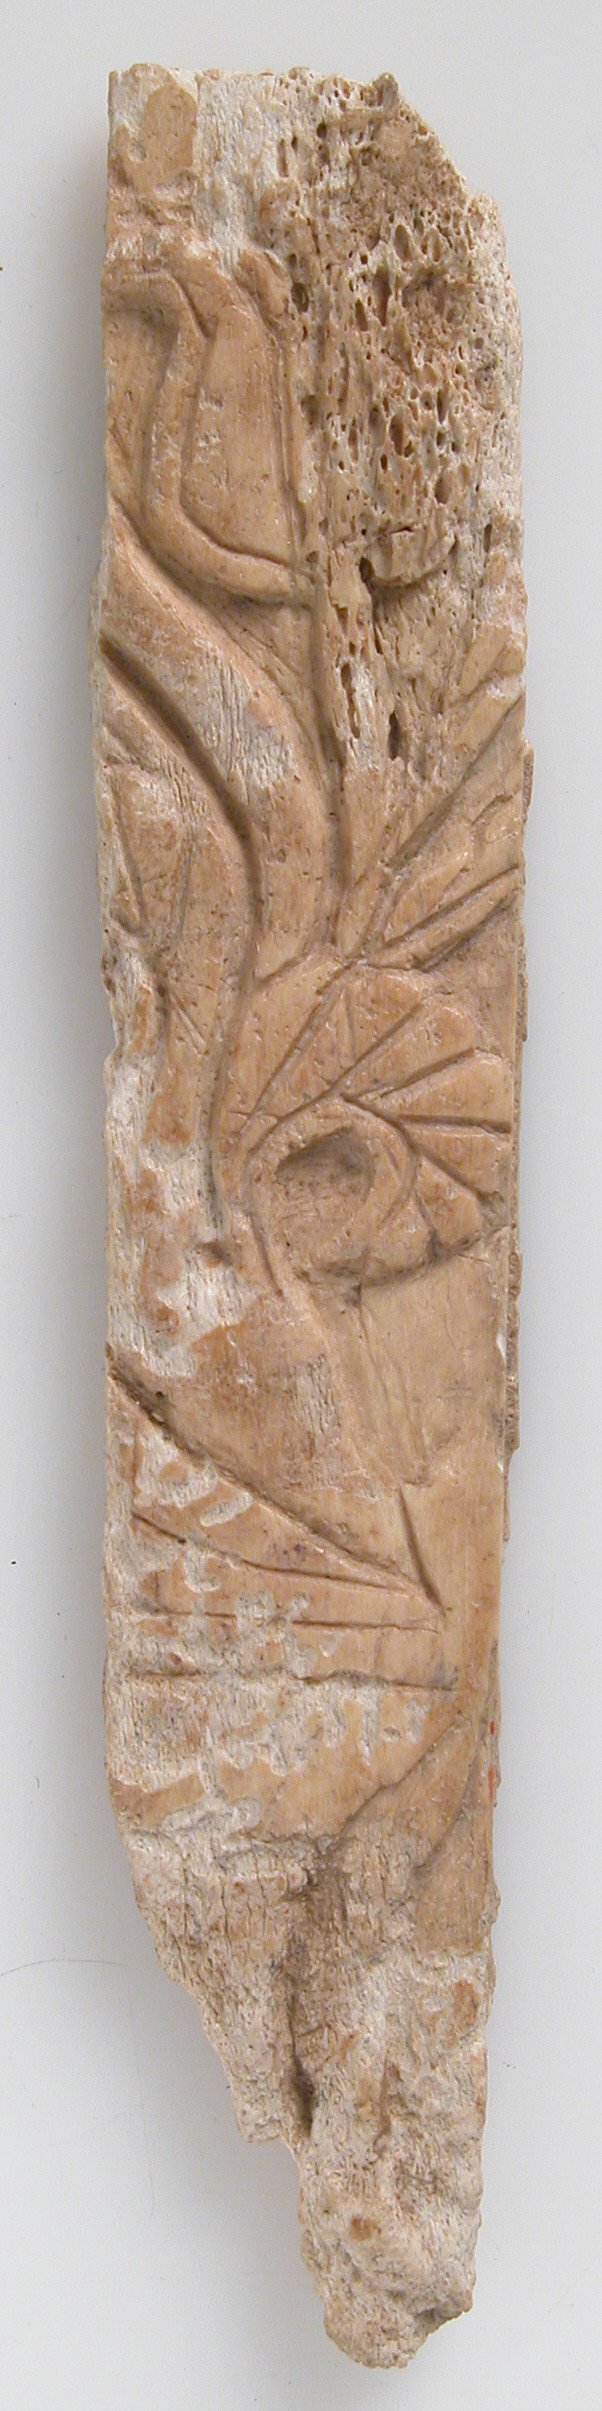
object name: fragment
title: Relief Fragment with Floral Design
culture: coptic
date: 501-700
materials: ivory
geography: egypt